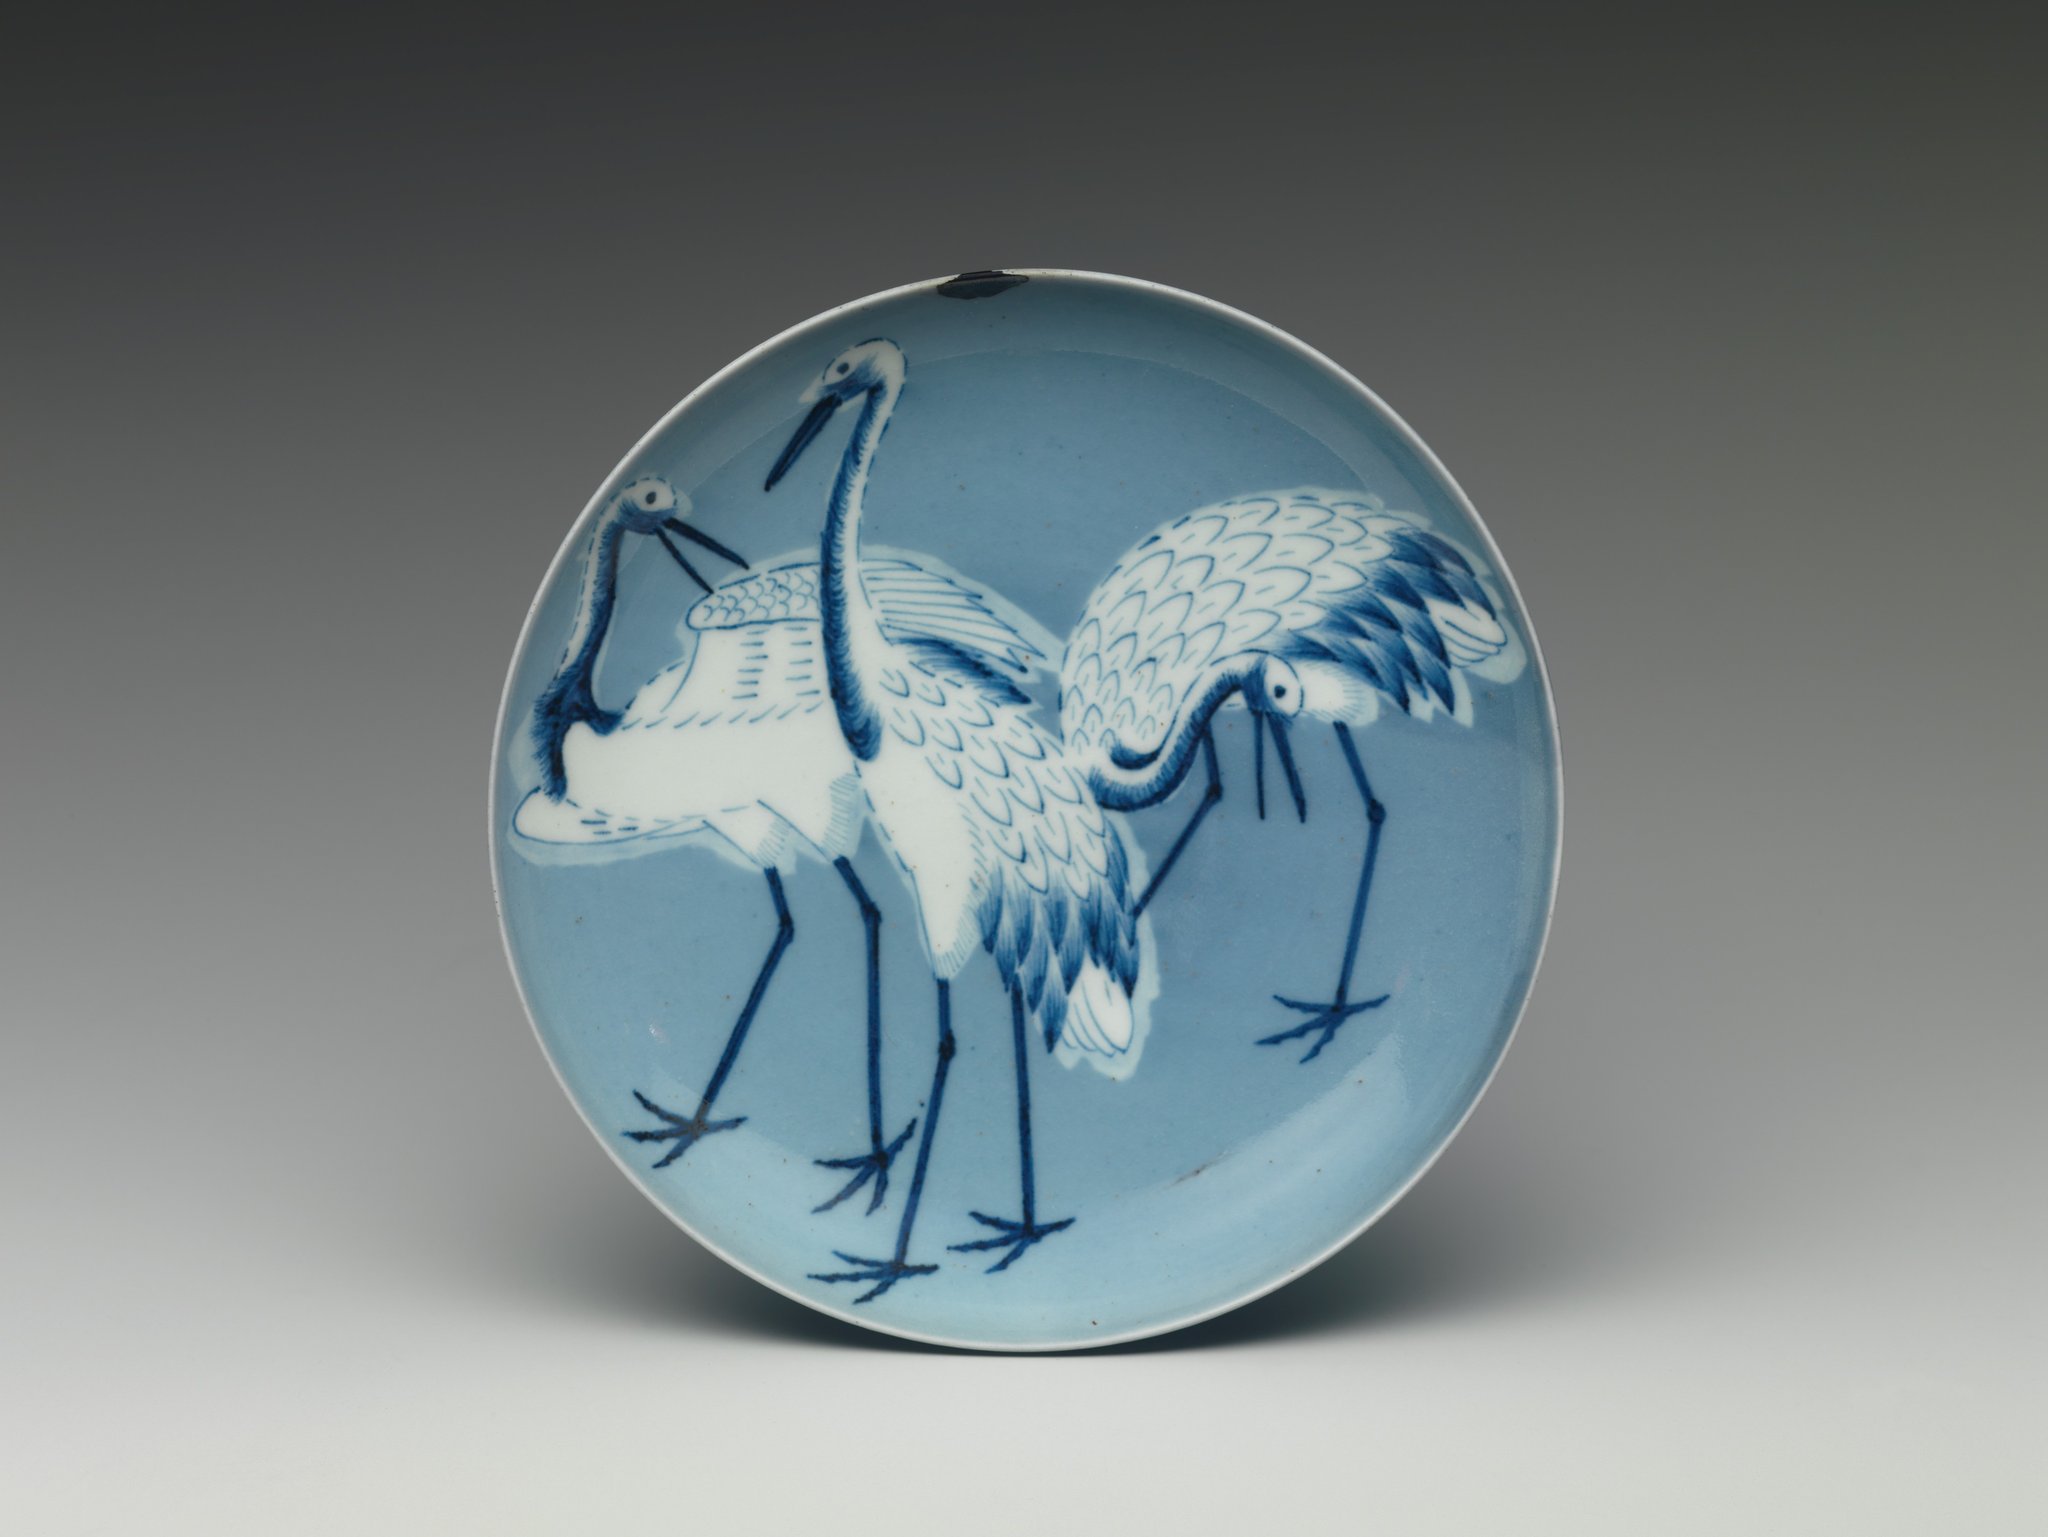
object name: dish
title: Dish with Cranes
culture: japanese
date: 1667-1700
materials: ceramic glaze, glaze, iron, porcelain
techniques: underglaze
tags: cranes